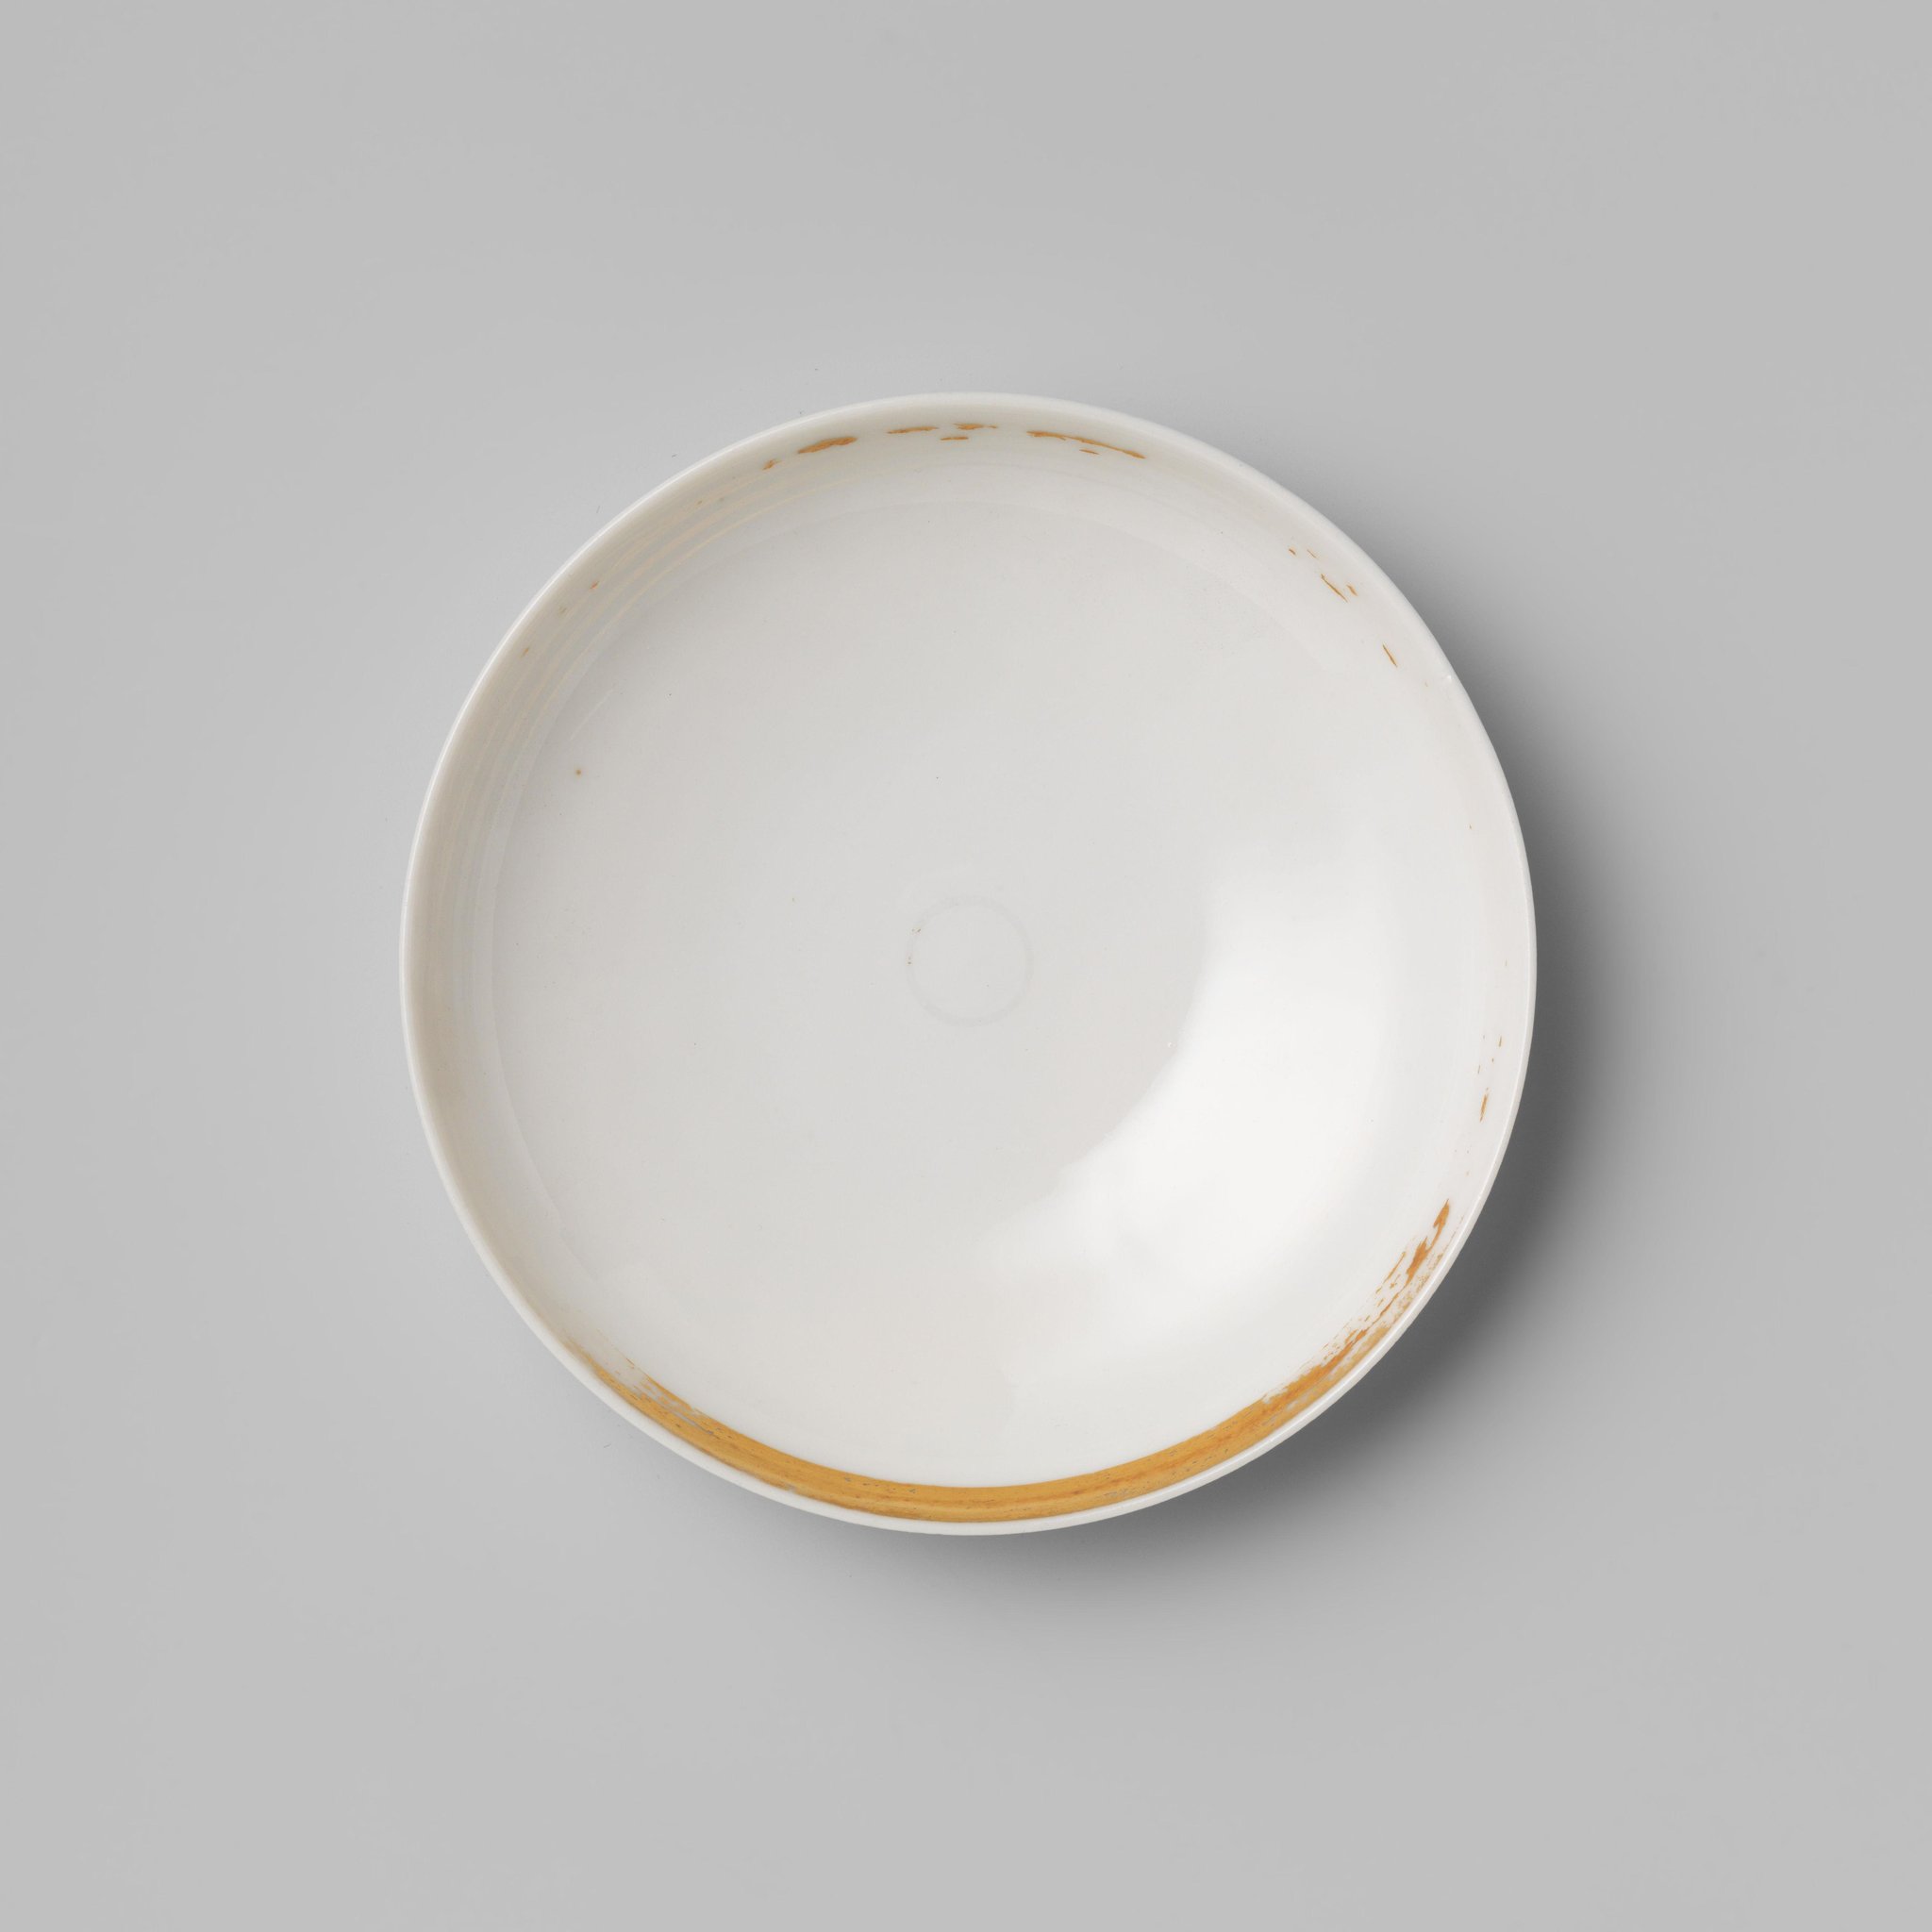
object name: platter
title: Saucer with a medallion and gold border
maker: Anonymous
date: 1850-1899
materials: glaze, gold, paint, porcelain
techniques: firing, forming, gilding, turning, vitrification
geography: europe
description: Schotel van porselein met langs de schotelrand een brede gouden bies en midden op het plat een gouden cirkel. Behoort bij een serie van twaalf kop en schotels waarvan de koppen zijn versierd met een drukdecor in zwart, voorstellende spelende kinderen of volwassenen in een landschap.